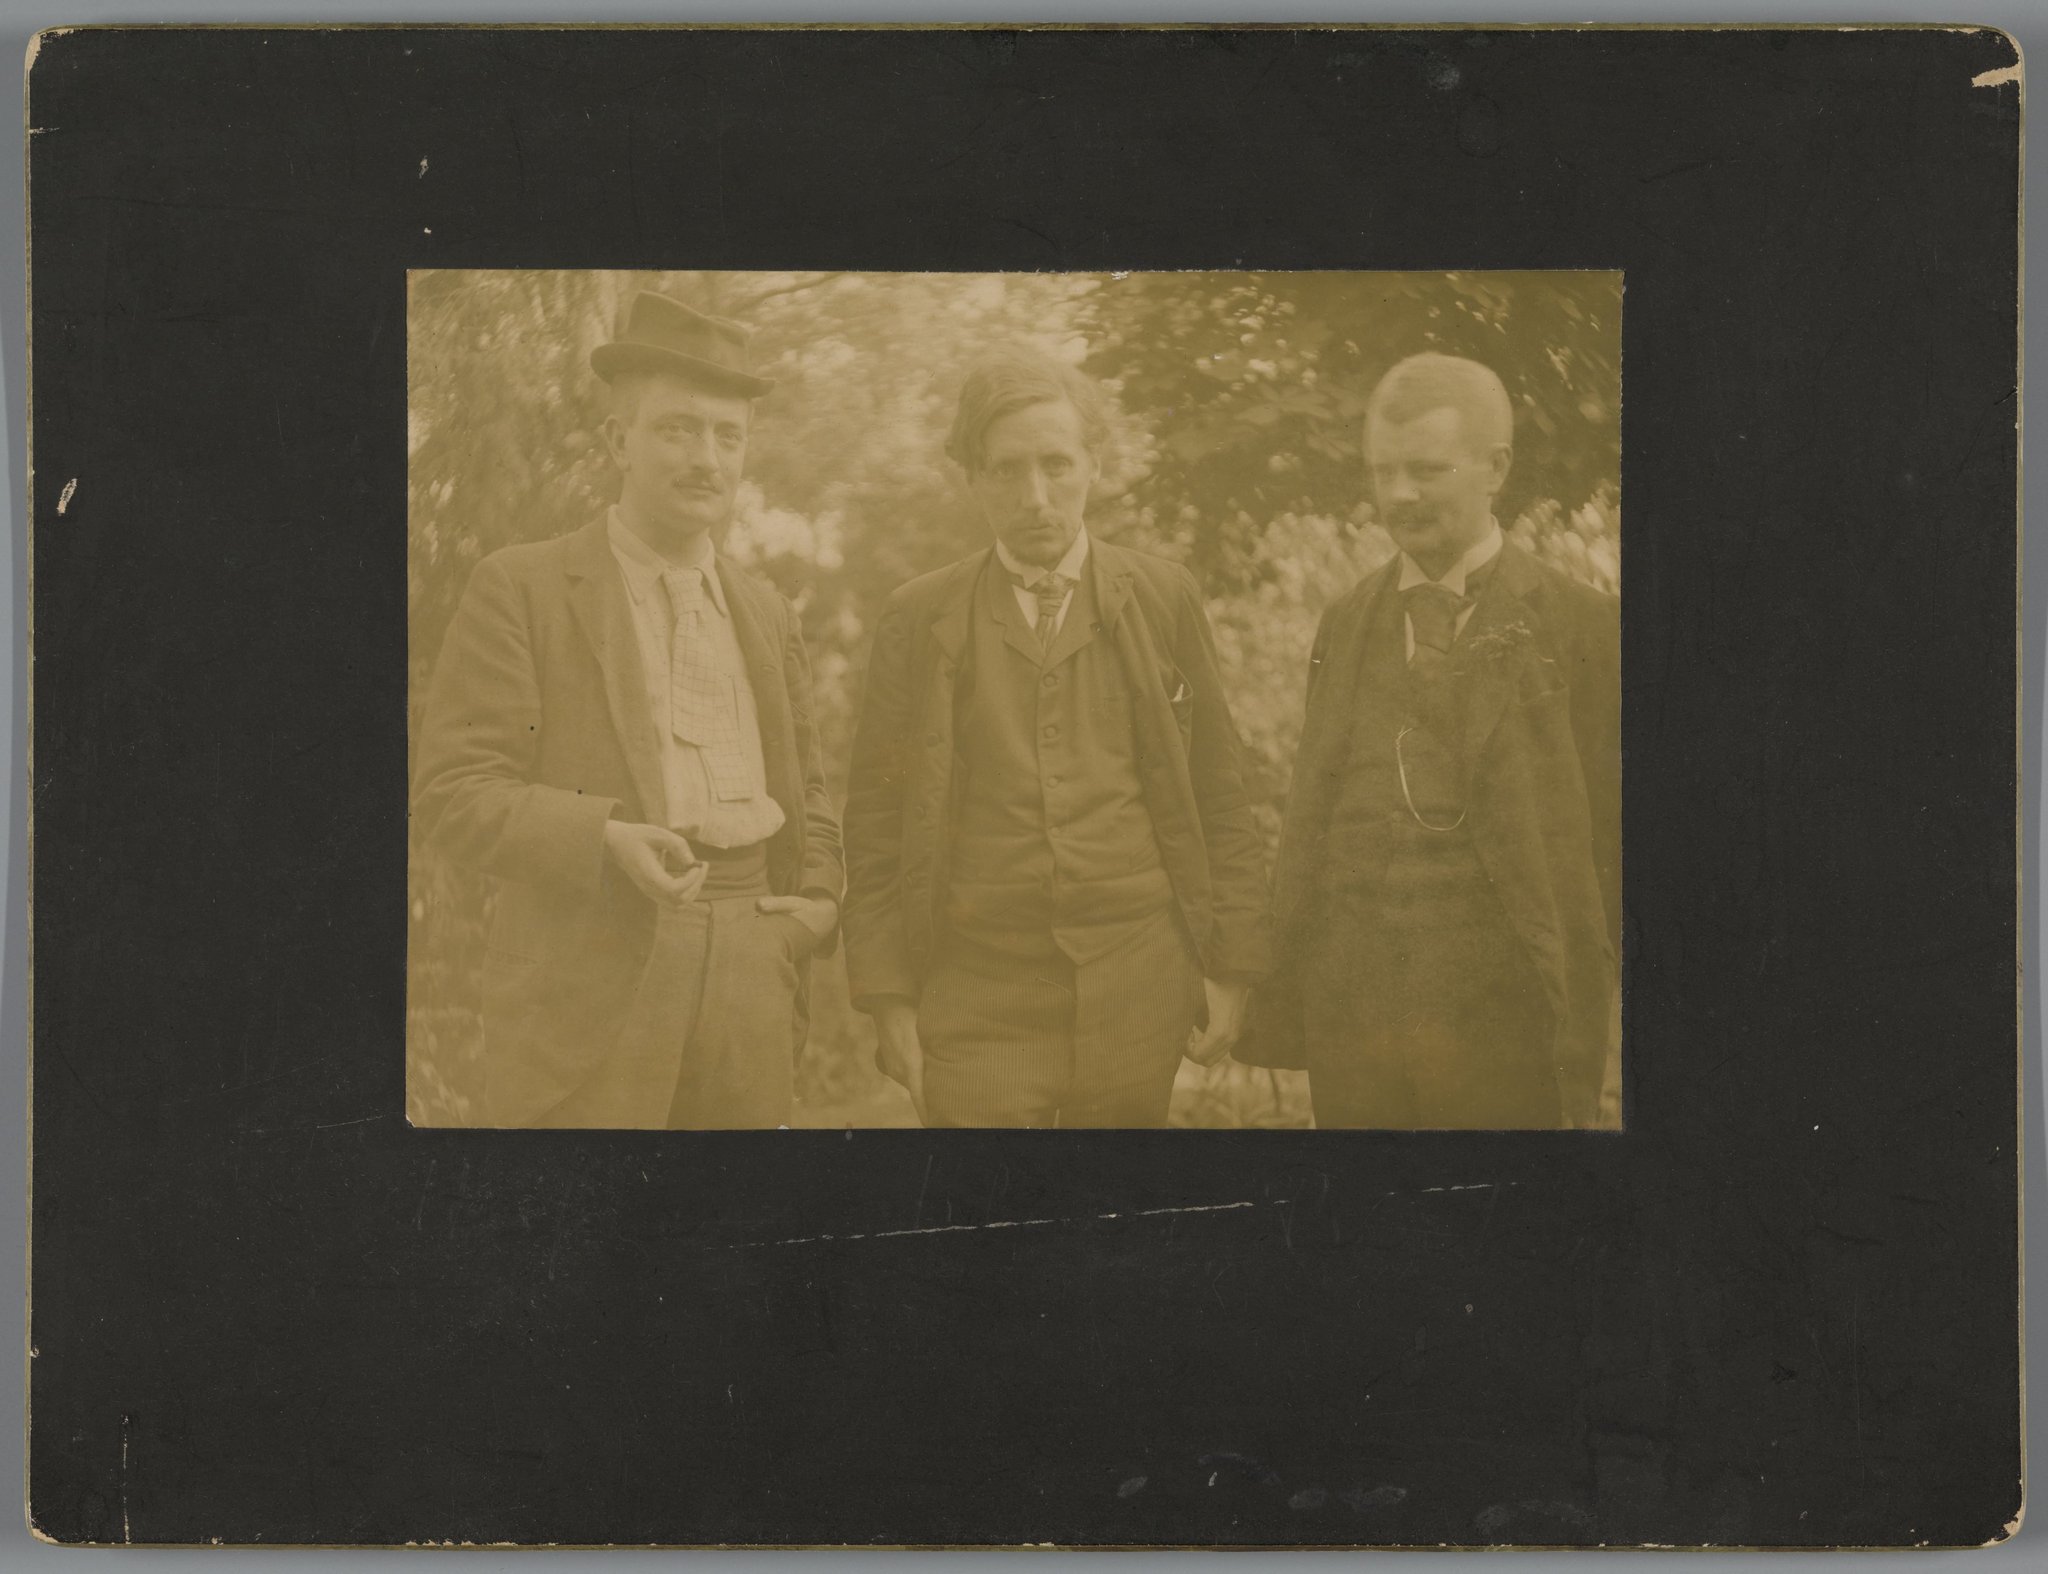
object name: photograph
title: Hofker, Kloos en Boeken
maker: willem witsen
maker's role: draughtsman, painter, print maker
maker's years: 1860-1923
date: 1860-1915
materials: cardboard, paper, photographic support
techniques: gelatin silver print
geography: amsterdam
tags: willem kloos